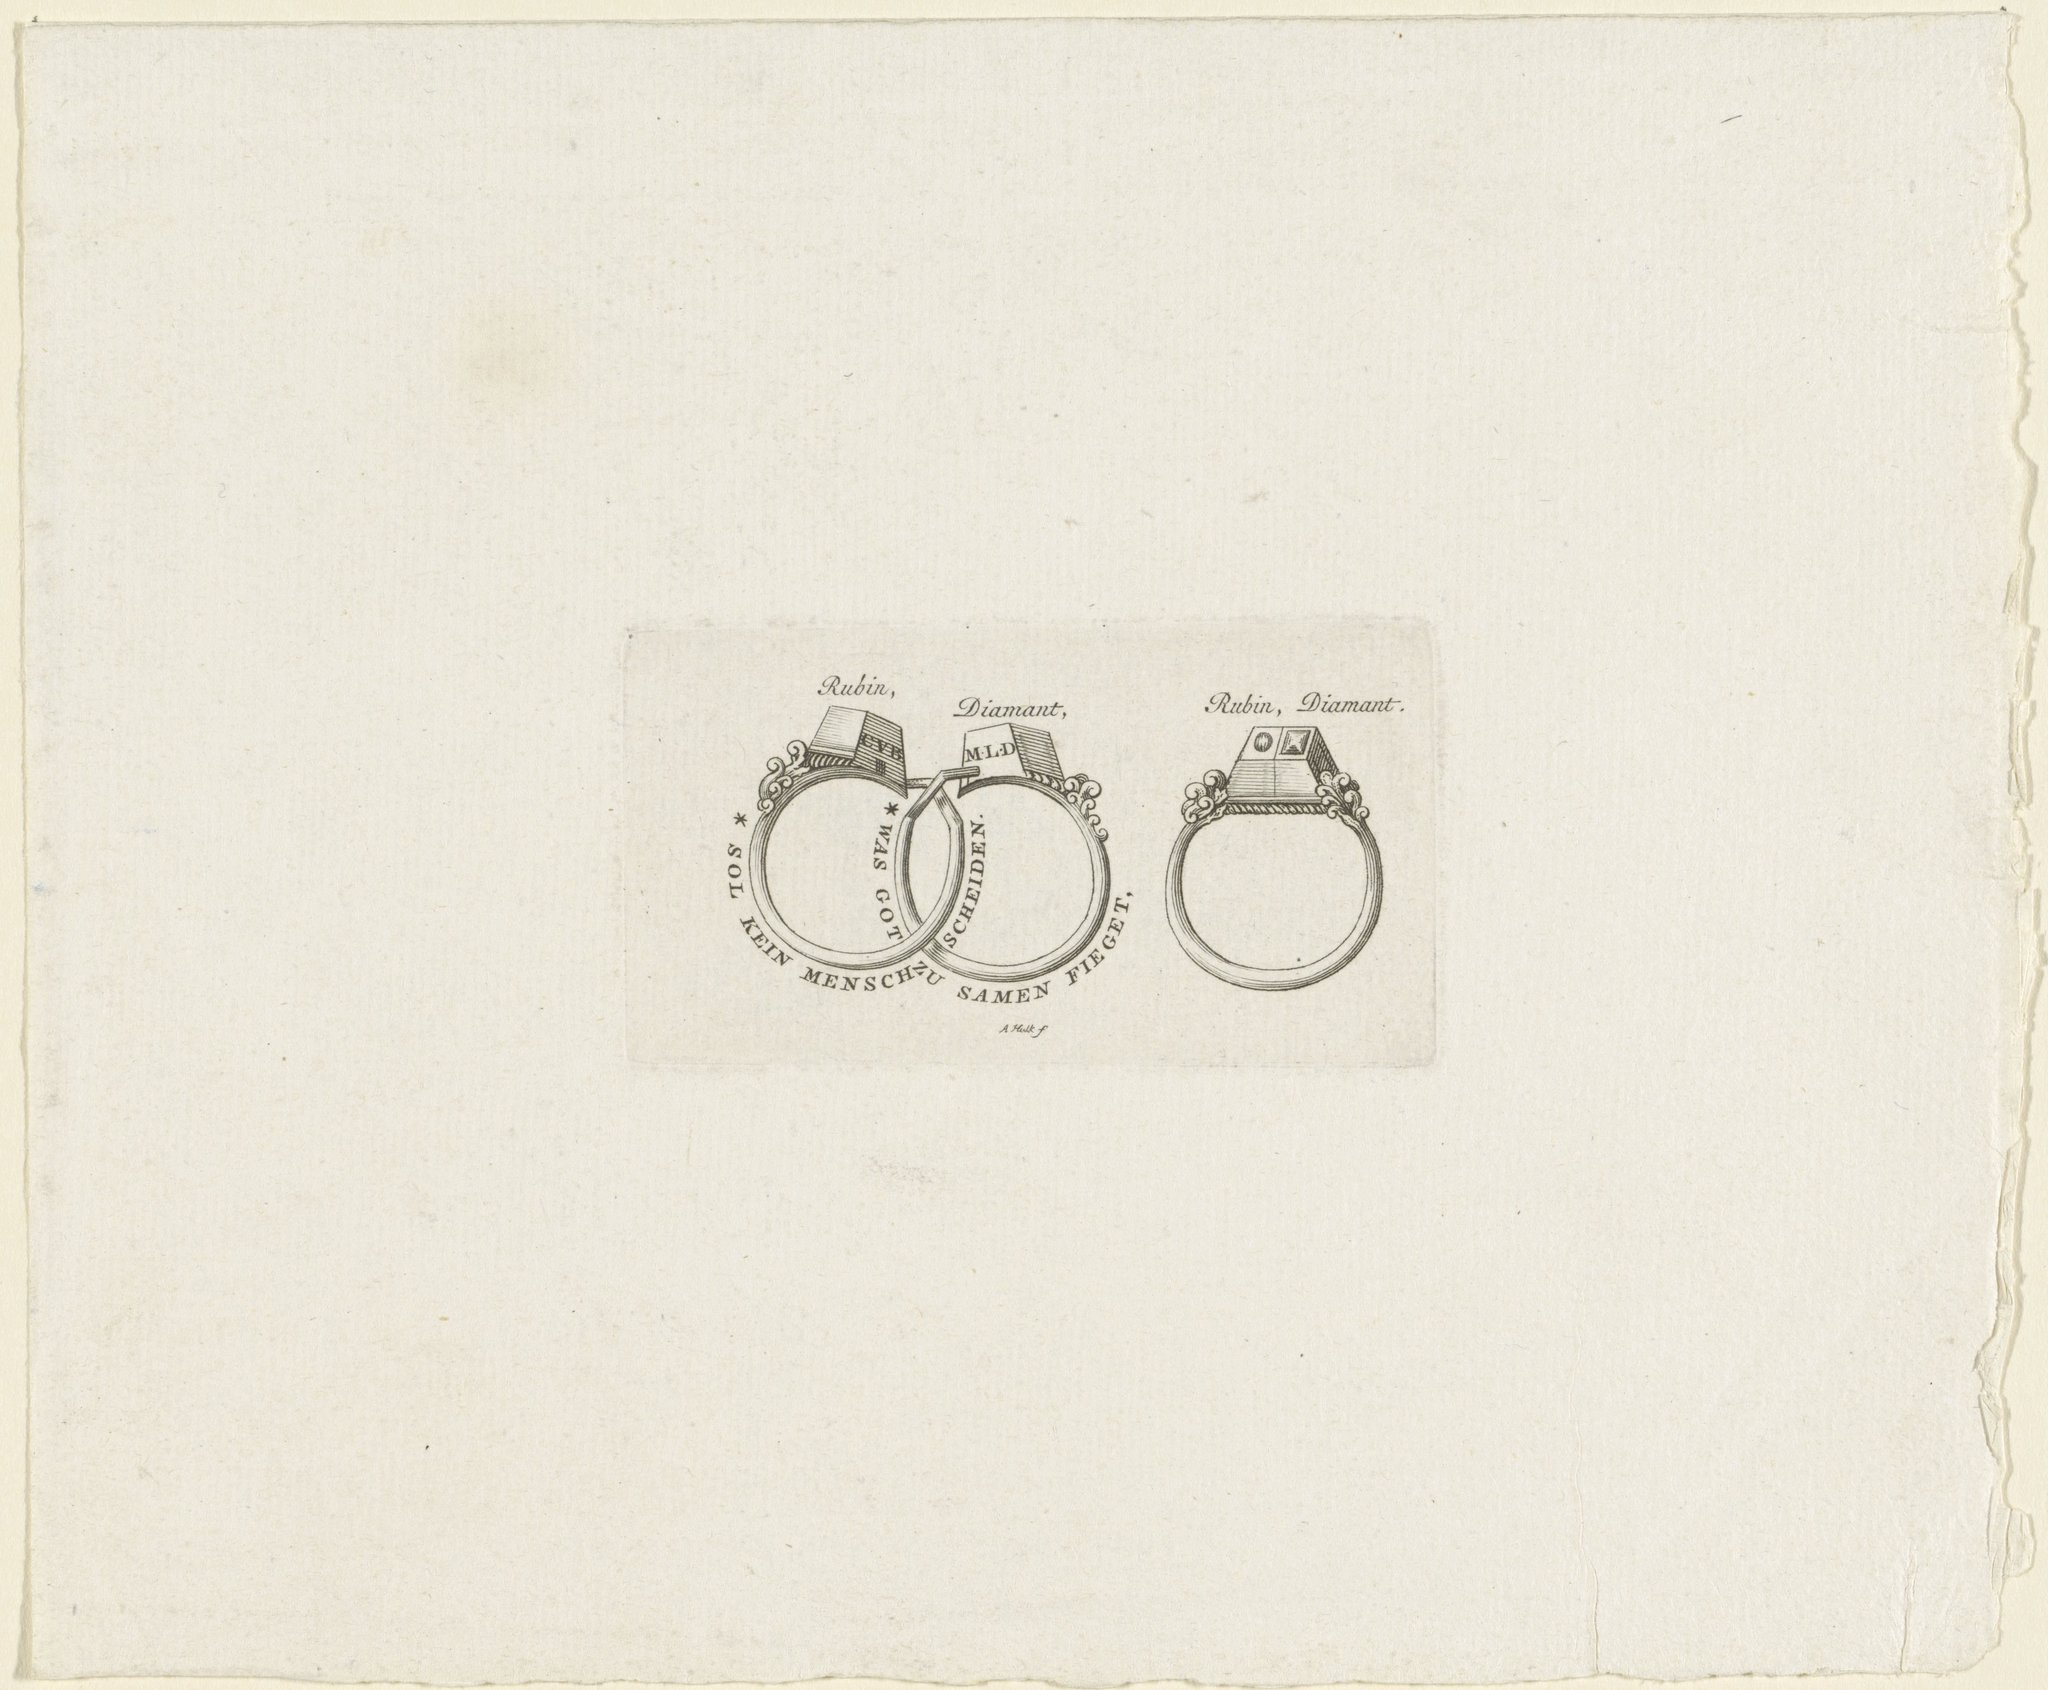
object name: print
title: Trouwring van Martin Luther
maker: abraham jacobsz. hulk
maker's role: print maker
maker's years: 1751-1817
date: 1761-1817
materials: paper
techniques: etching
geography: netherlands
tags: priest, martin luther, wedding ring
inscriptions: collector's mark: Lugt 2228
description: De gouden dubbele trouwring van Martin Luther ingelegd met een robijn en een diamant. Links de ring in twee ringen gesplitst, rechts het geheel. Links het monogram CVB van Catharina van Bora en rechts het monogram MLD van Martin Luther Doctor. Rond de ringen de tekst: Was Got zu samen fieget, sol kein mensch scheiden.